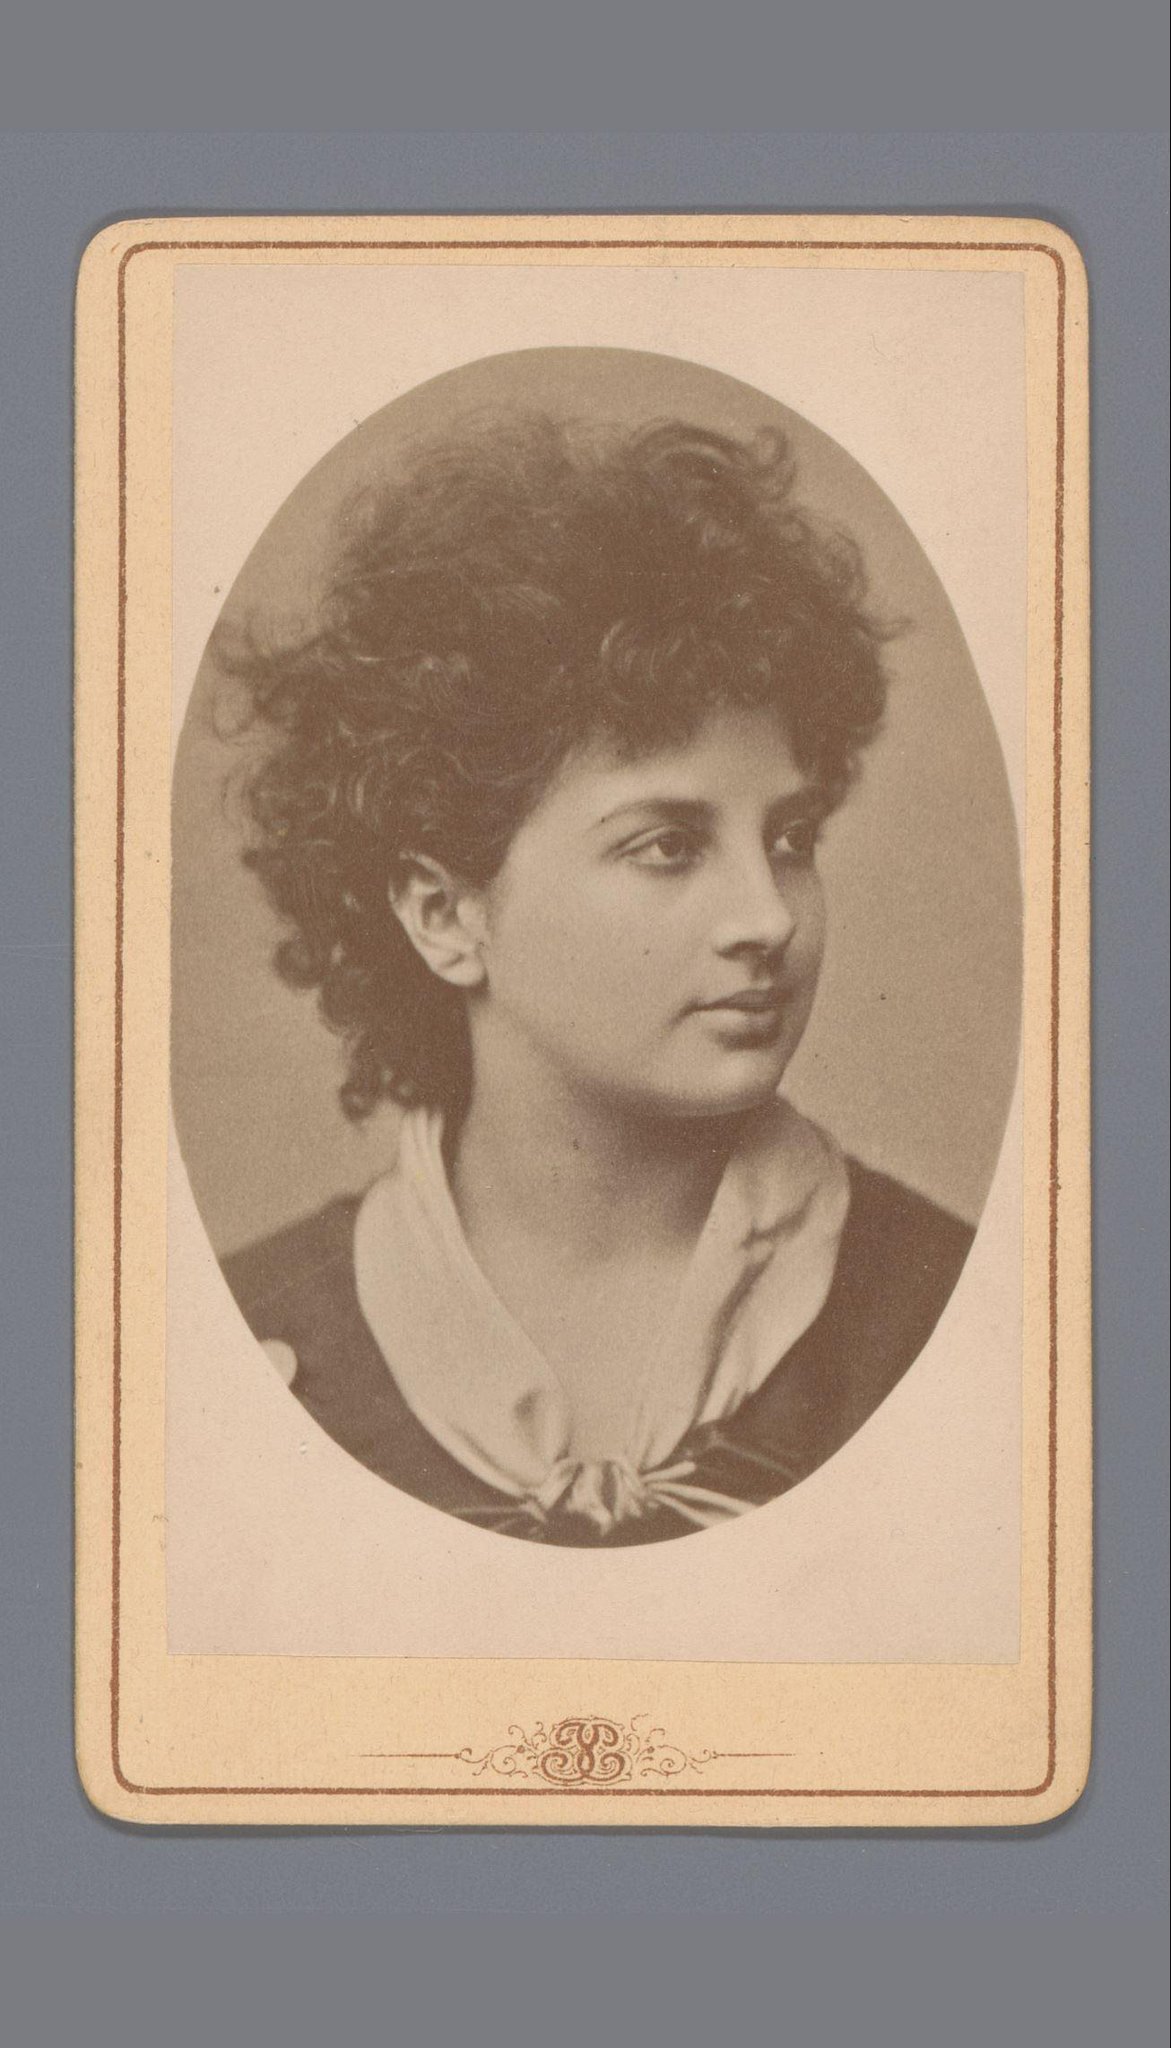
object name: photograph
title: Portret van een onbekende vrouw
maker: j. johansson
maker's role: fotograaf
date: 1870-1885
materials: cardboard, paper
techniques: albumen print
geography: sweden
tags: adolescent, young woman, maiden, historical persons - bb - woman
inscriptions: inscription: ‘J. JOHANSSON/ FOTOGRAF/ FOTOGRAFISK/ KONST-HANDLARE’